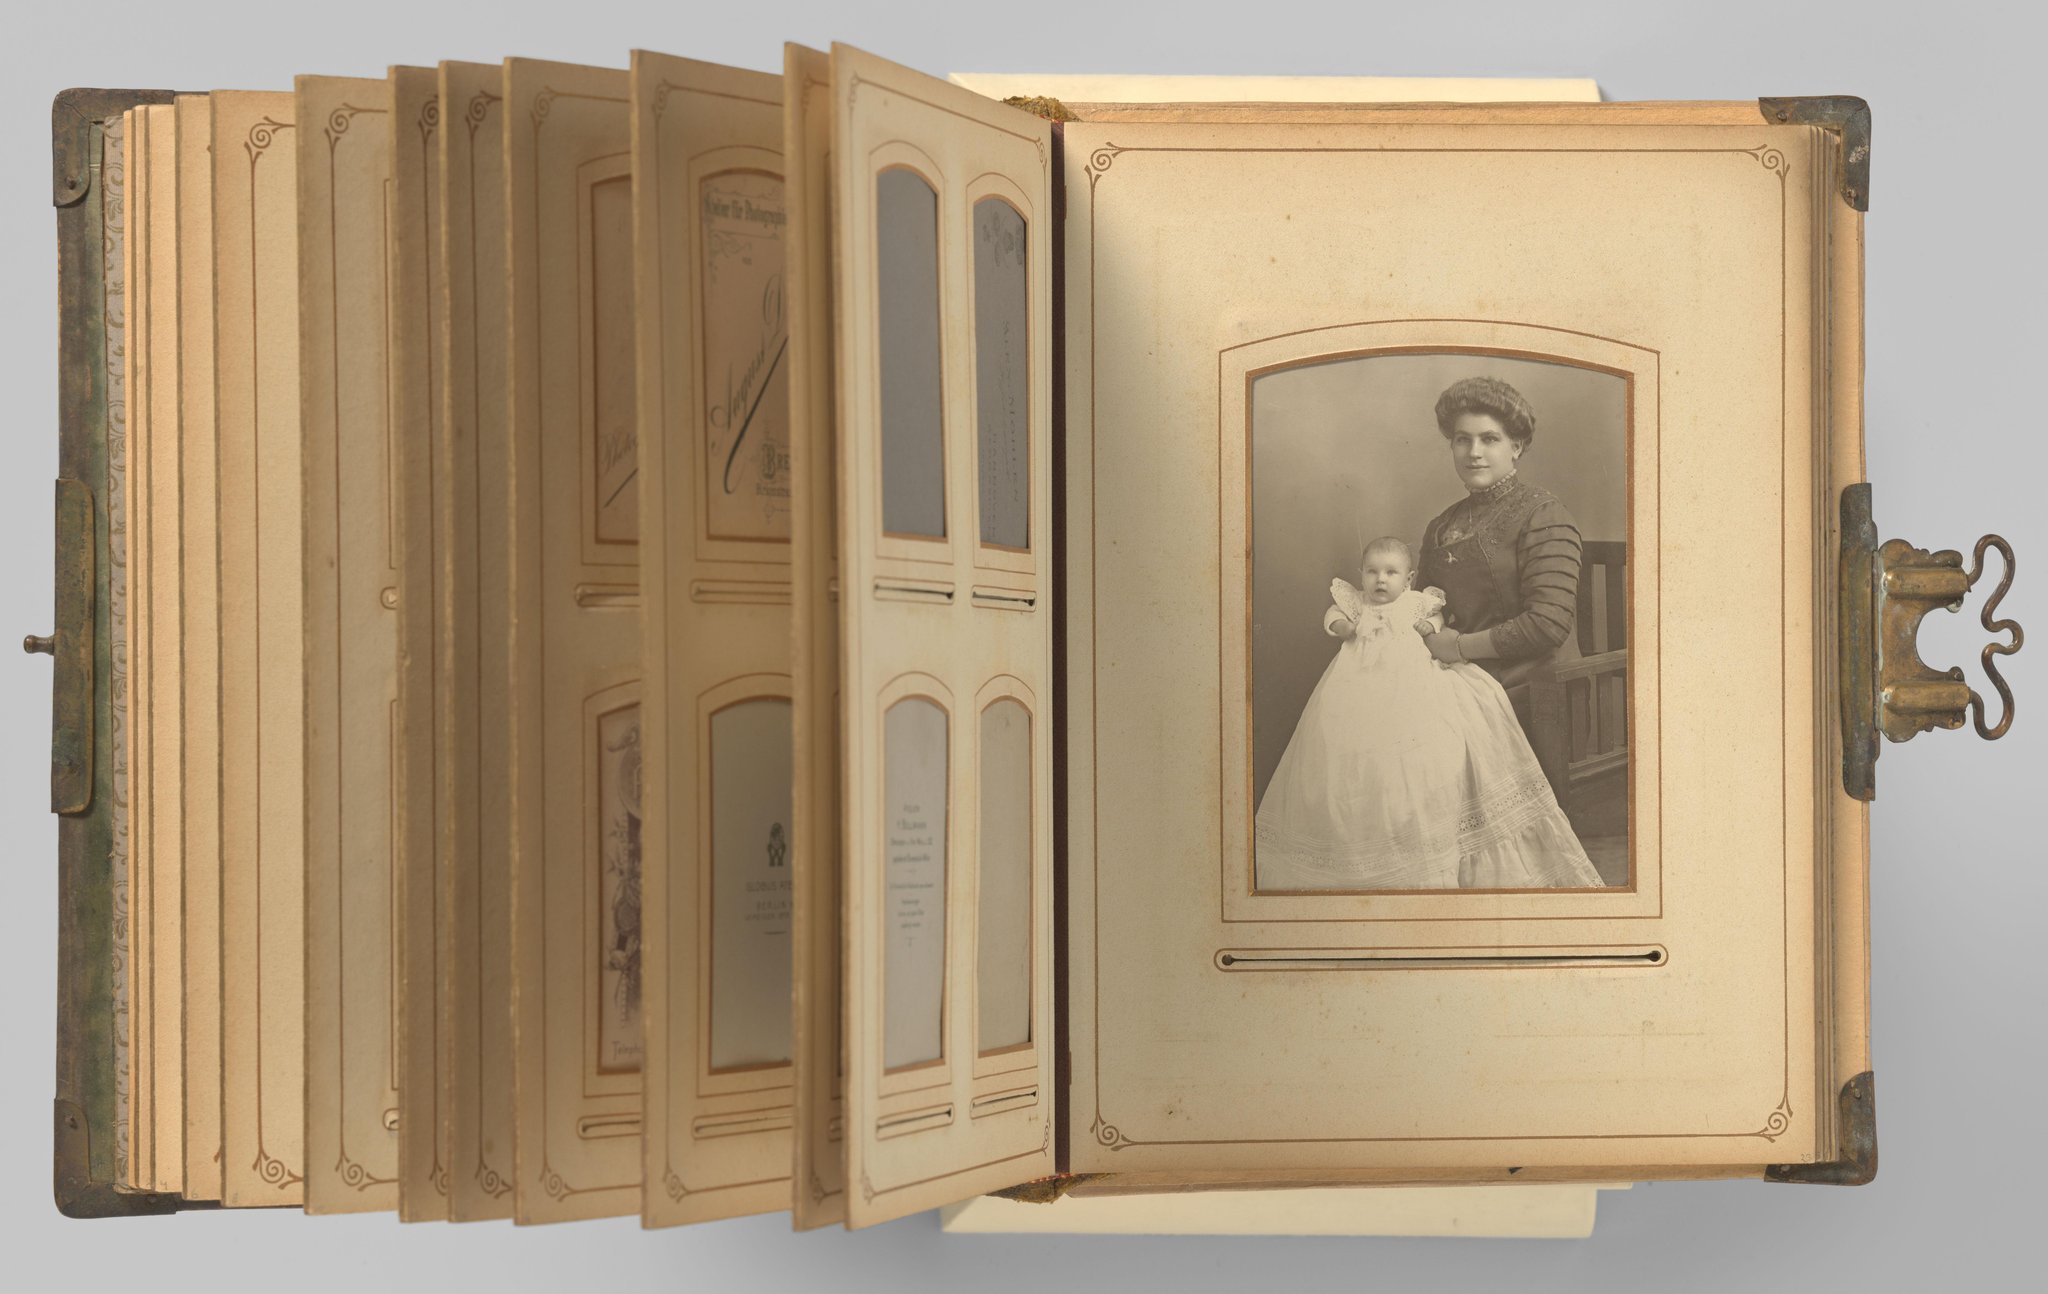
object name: photograph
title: Portret van een zittende vrouw met een baby in doopjurk op schoot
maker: th. siebert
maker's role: fotograaf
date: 1895-1920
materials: cardboard, photographic support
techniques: collodion silver print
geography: bremen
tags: sitting figure - aa - female human figure, historical persons - bb - woman, baptism, christening gown, infant, baby ~ the ages of man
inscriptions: inscription: ‘Atelier für moderne/ künstlerische Fotografie/ Th. Siebert/ BREMEN. Fehrfeld 61./ Platte bleibt für/ Vergrösserungen u./ Nachbestellungen/ aufbewahrt.’